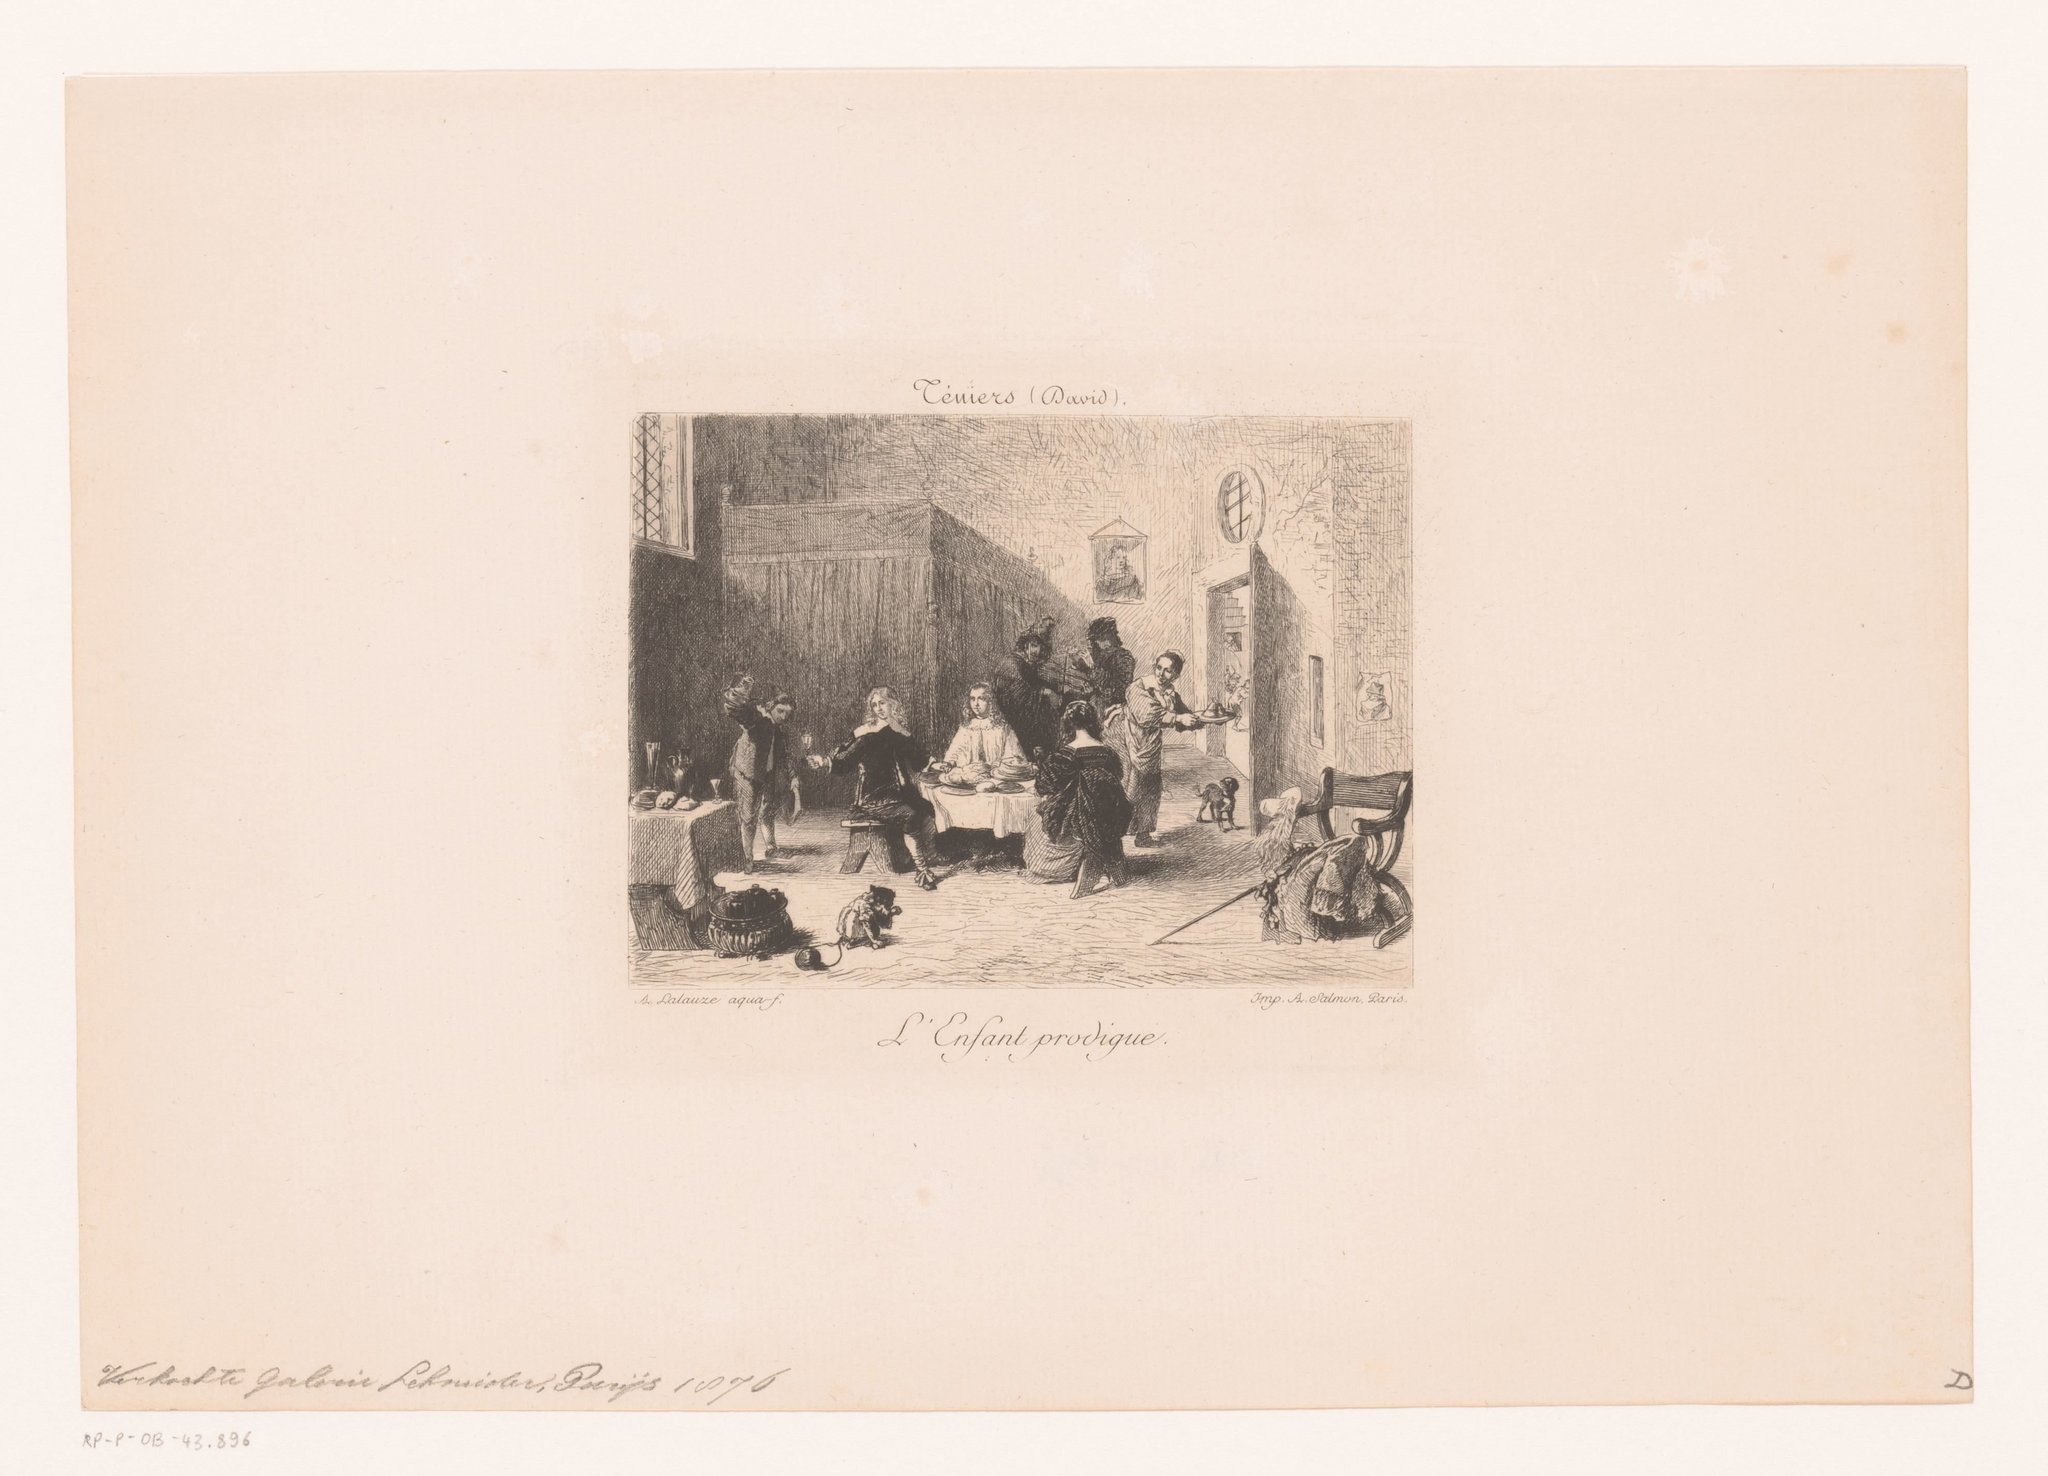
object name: print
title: L'Enfant prodigue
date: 1848-1875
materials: paper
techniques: drypoint, etching, intaglio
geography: france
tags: interior of the house, the parable of the prodigal son (luke 15:11-32)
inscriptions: collector's mark: Lugt 2228